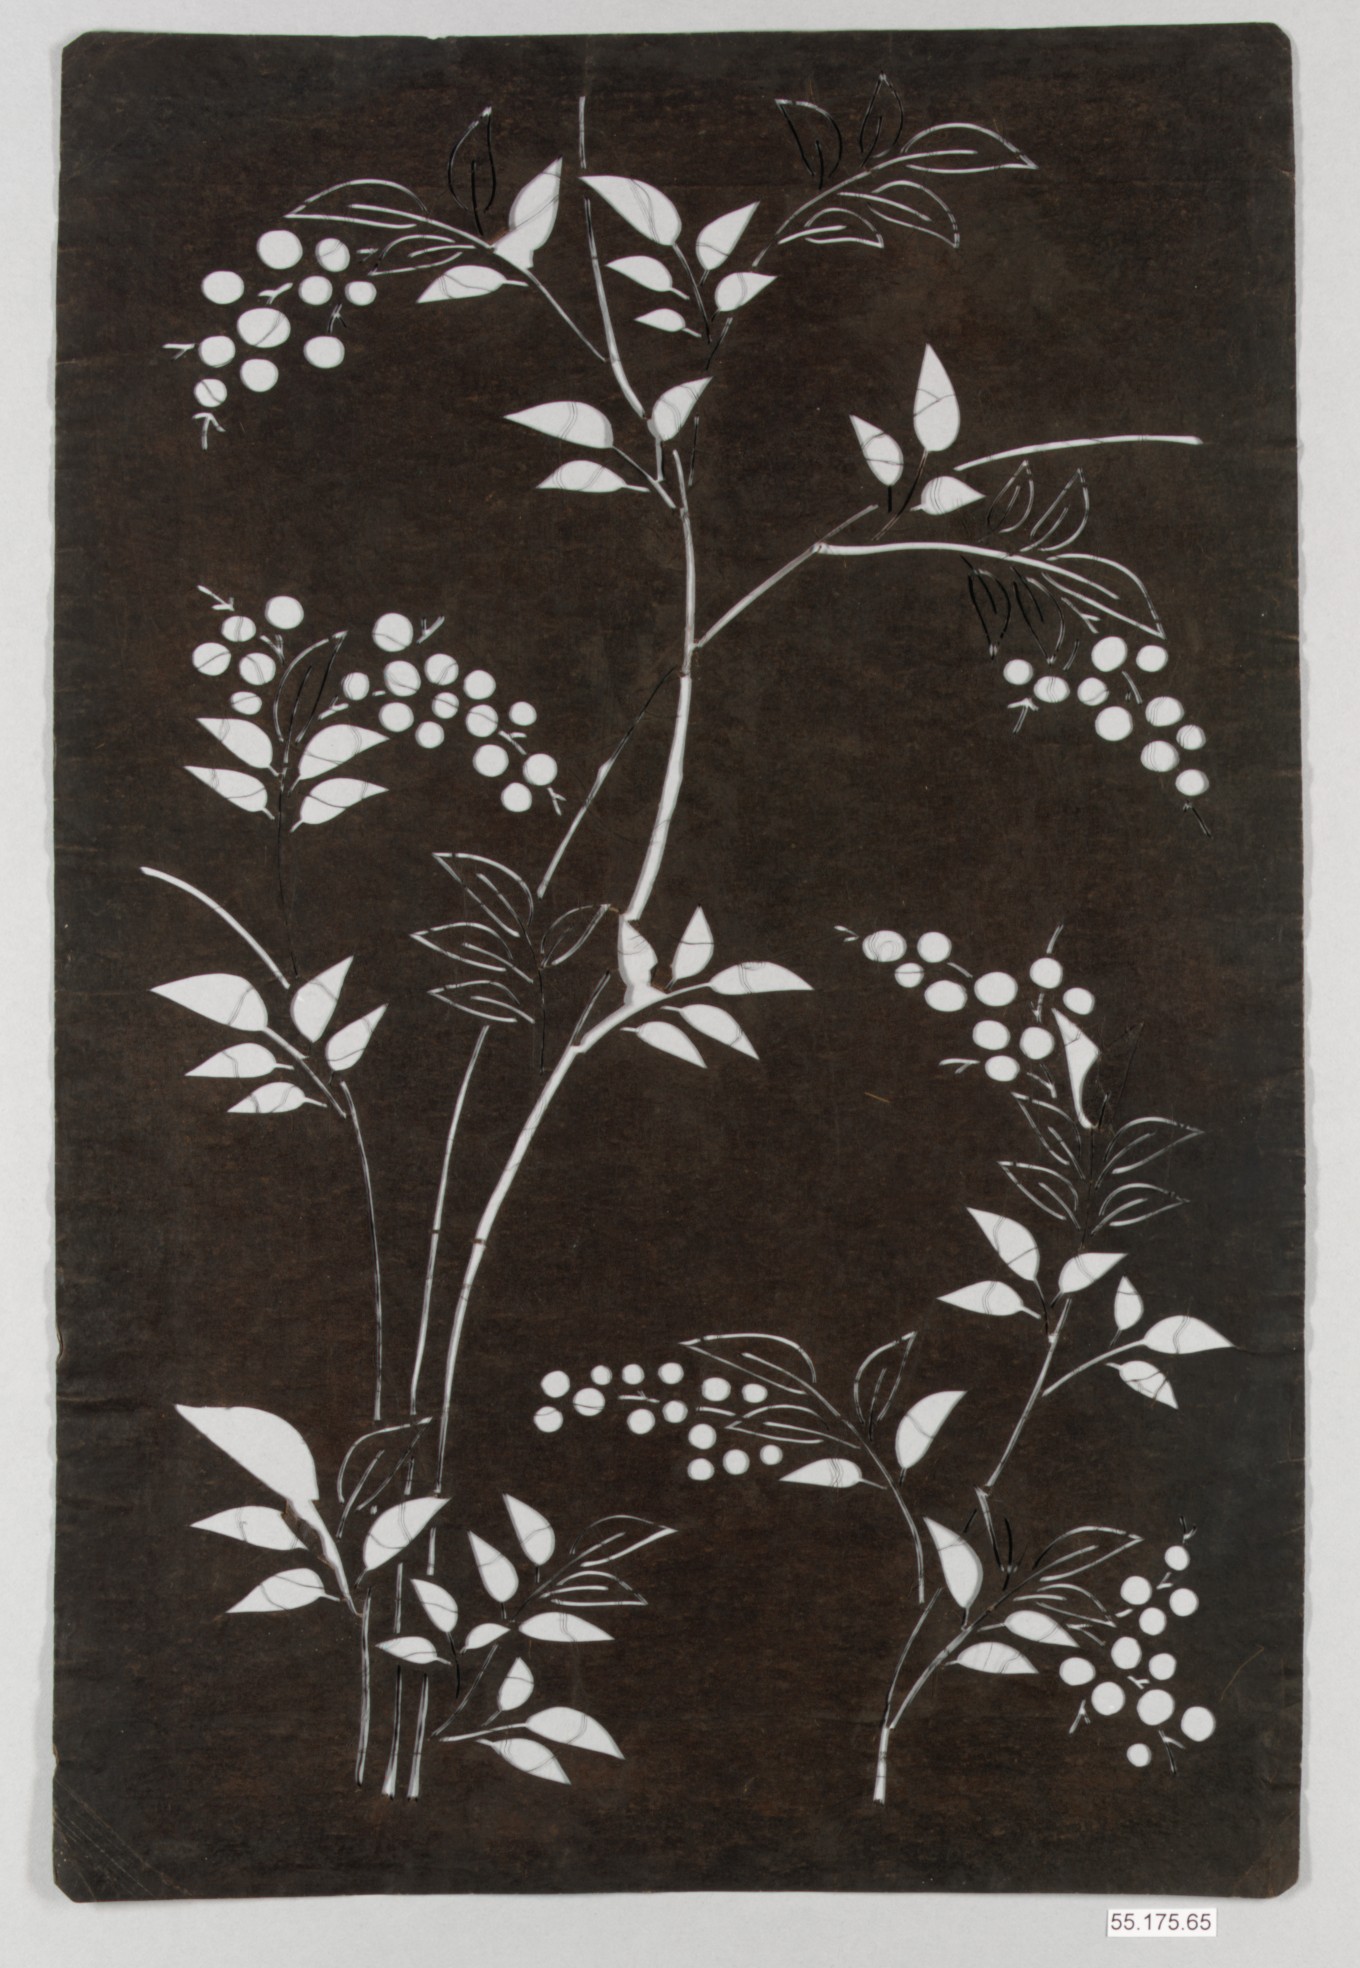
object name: stencil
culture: japanese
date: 1801-1900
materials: paper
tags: fruit,plants